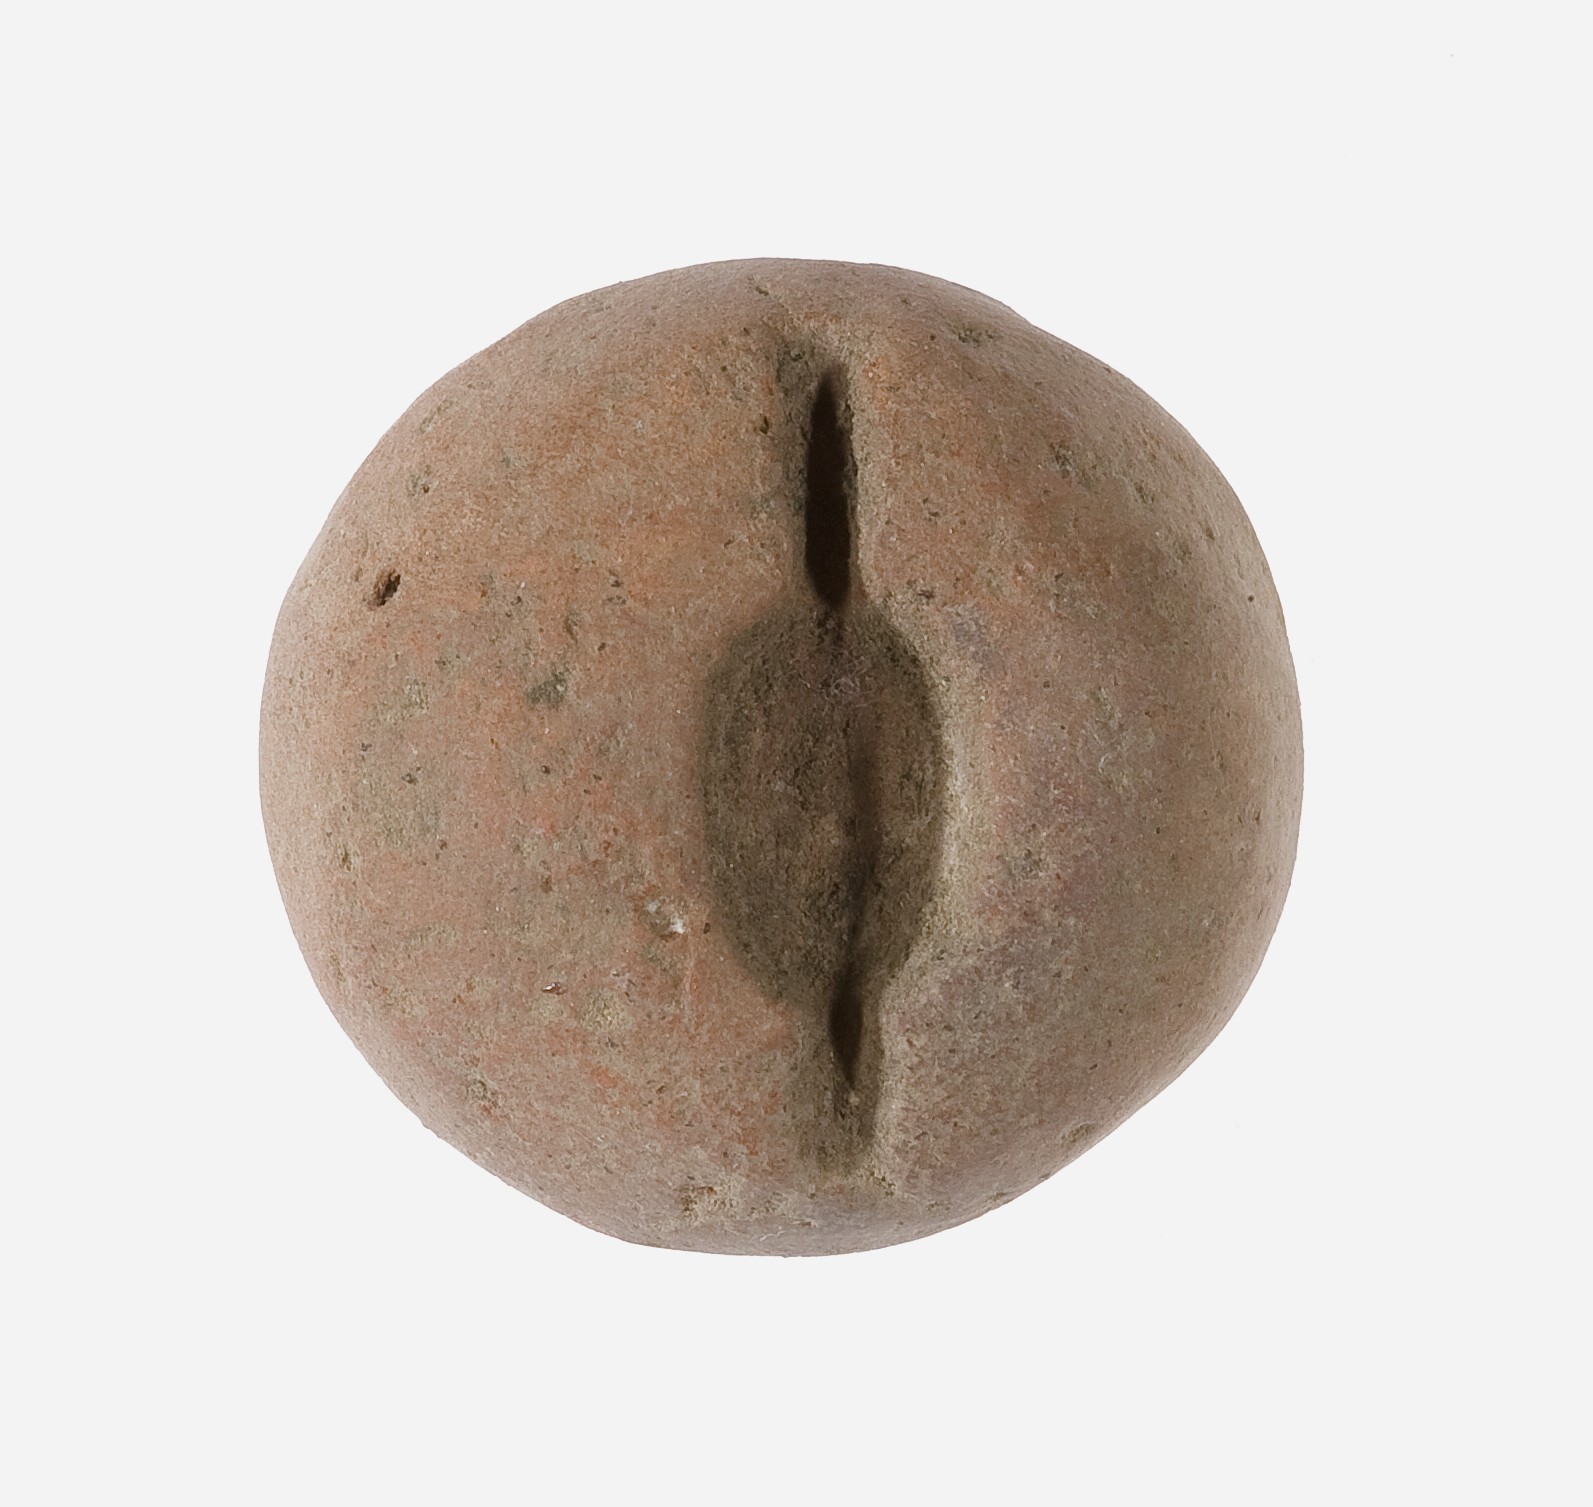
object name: mold, bead. ovoid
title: Mold for Small Ovoid Bead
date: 1390-1352 BCE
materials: pottery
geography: egypt